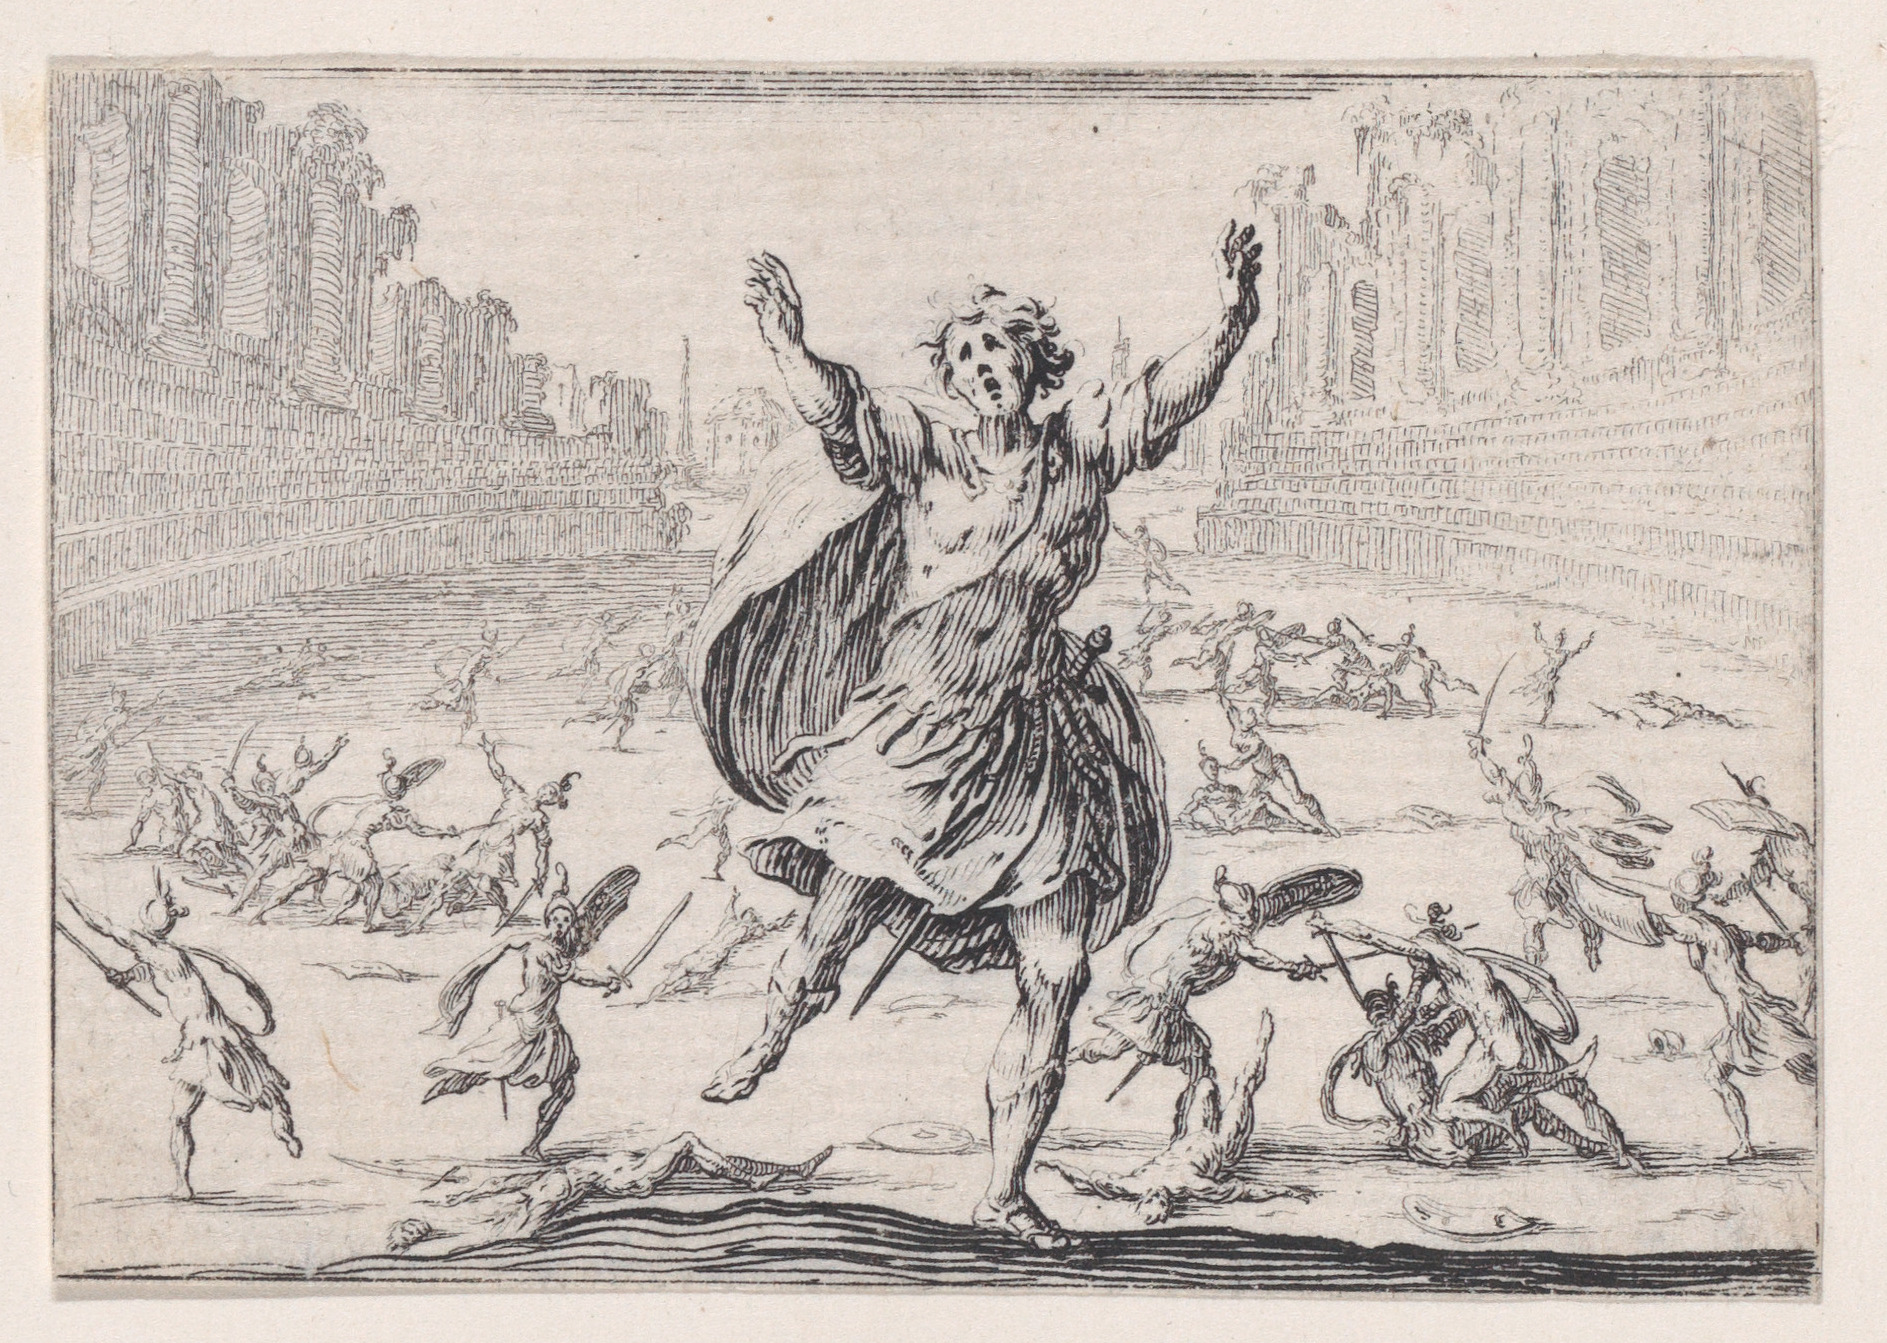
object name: print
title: Escarmouche dans un Cirque (Skirmish in a Circus), from "Les Caprices" Series A, The Florence Set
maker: jacques callot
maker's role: artist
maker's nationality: french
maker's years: 1592-1635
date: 1617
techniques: etching